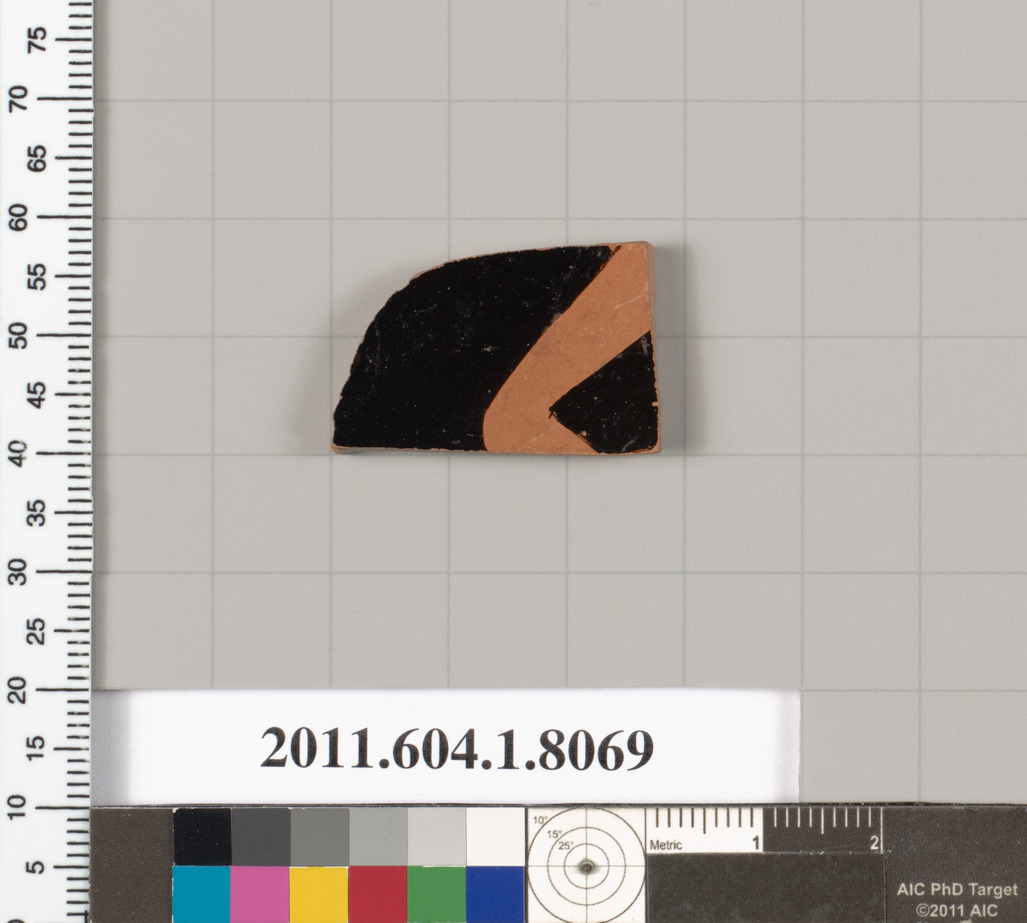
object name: kylix fragment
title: Terracotta fragment of a kylix (drinking cup)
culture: greek, attic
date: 510-500 BCE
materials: terracotta